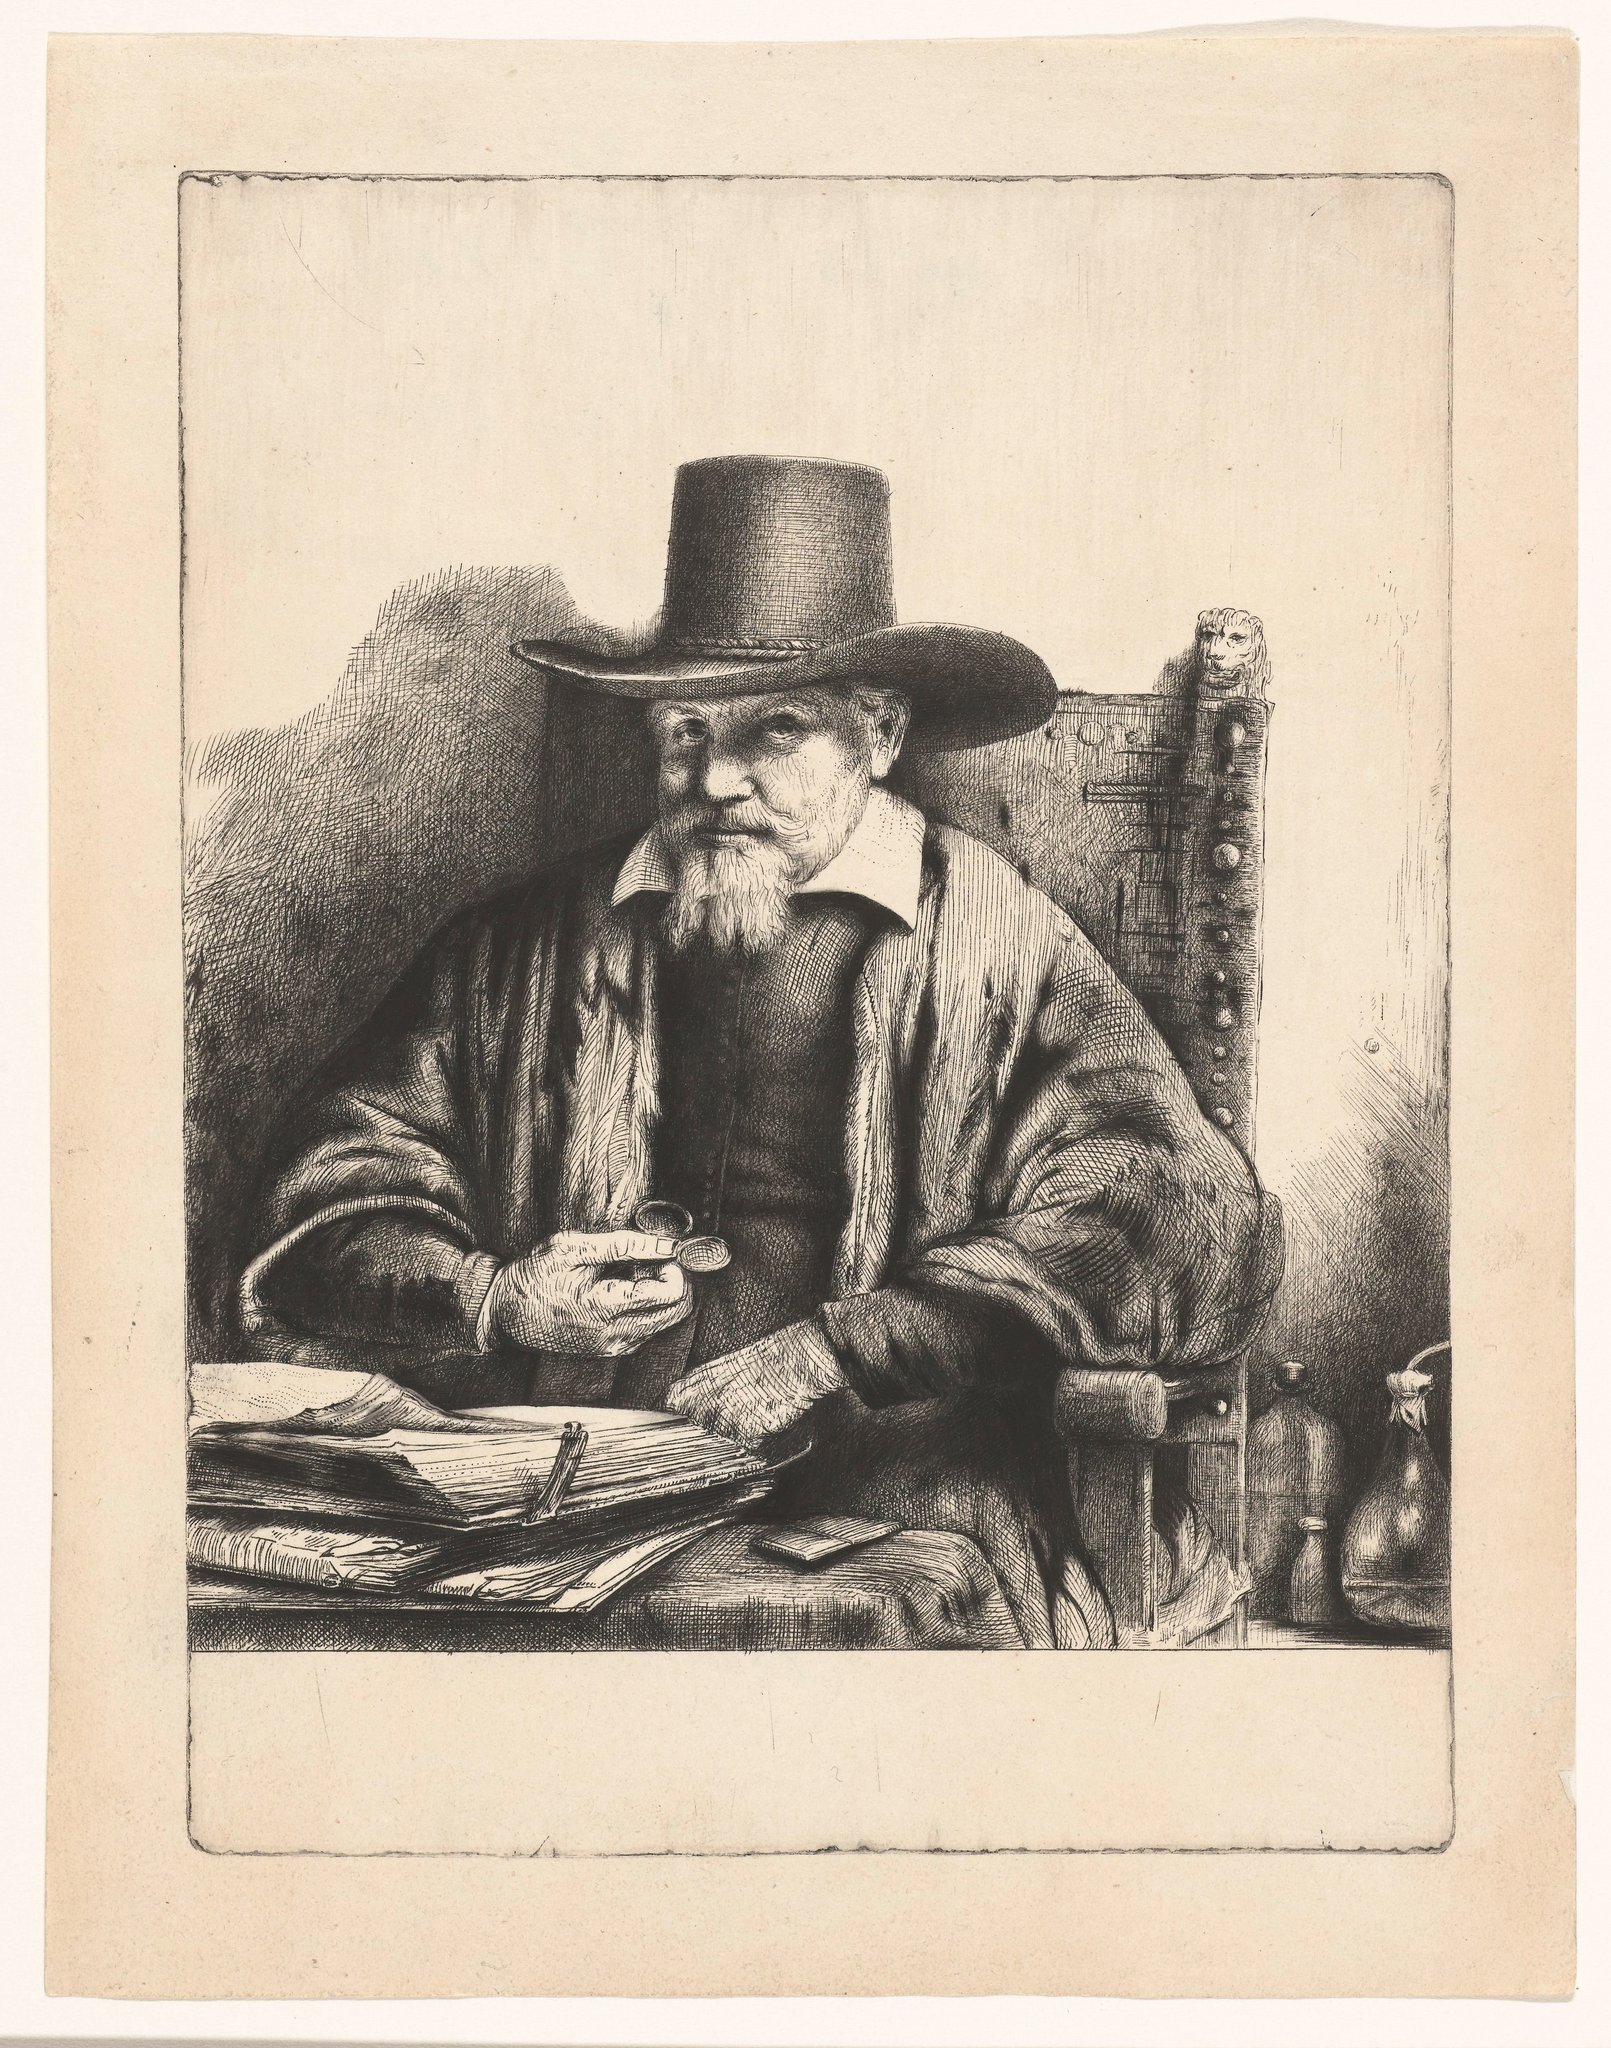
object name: print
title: Arnout Tholinx, inspector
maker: Anonymous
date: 1656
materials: paper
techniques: etching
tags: historical persons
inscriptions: collector's mark: Lugt 2228, collector's mark: Lugt 2760